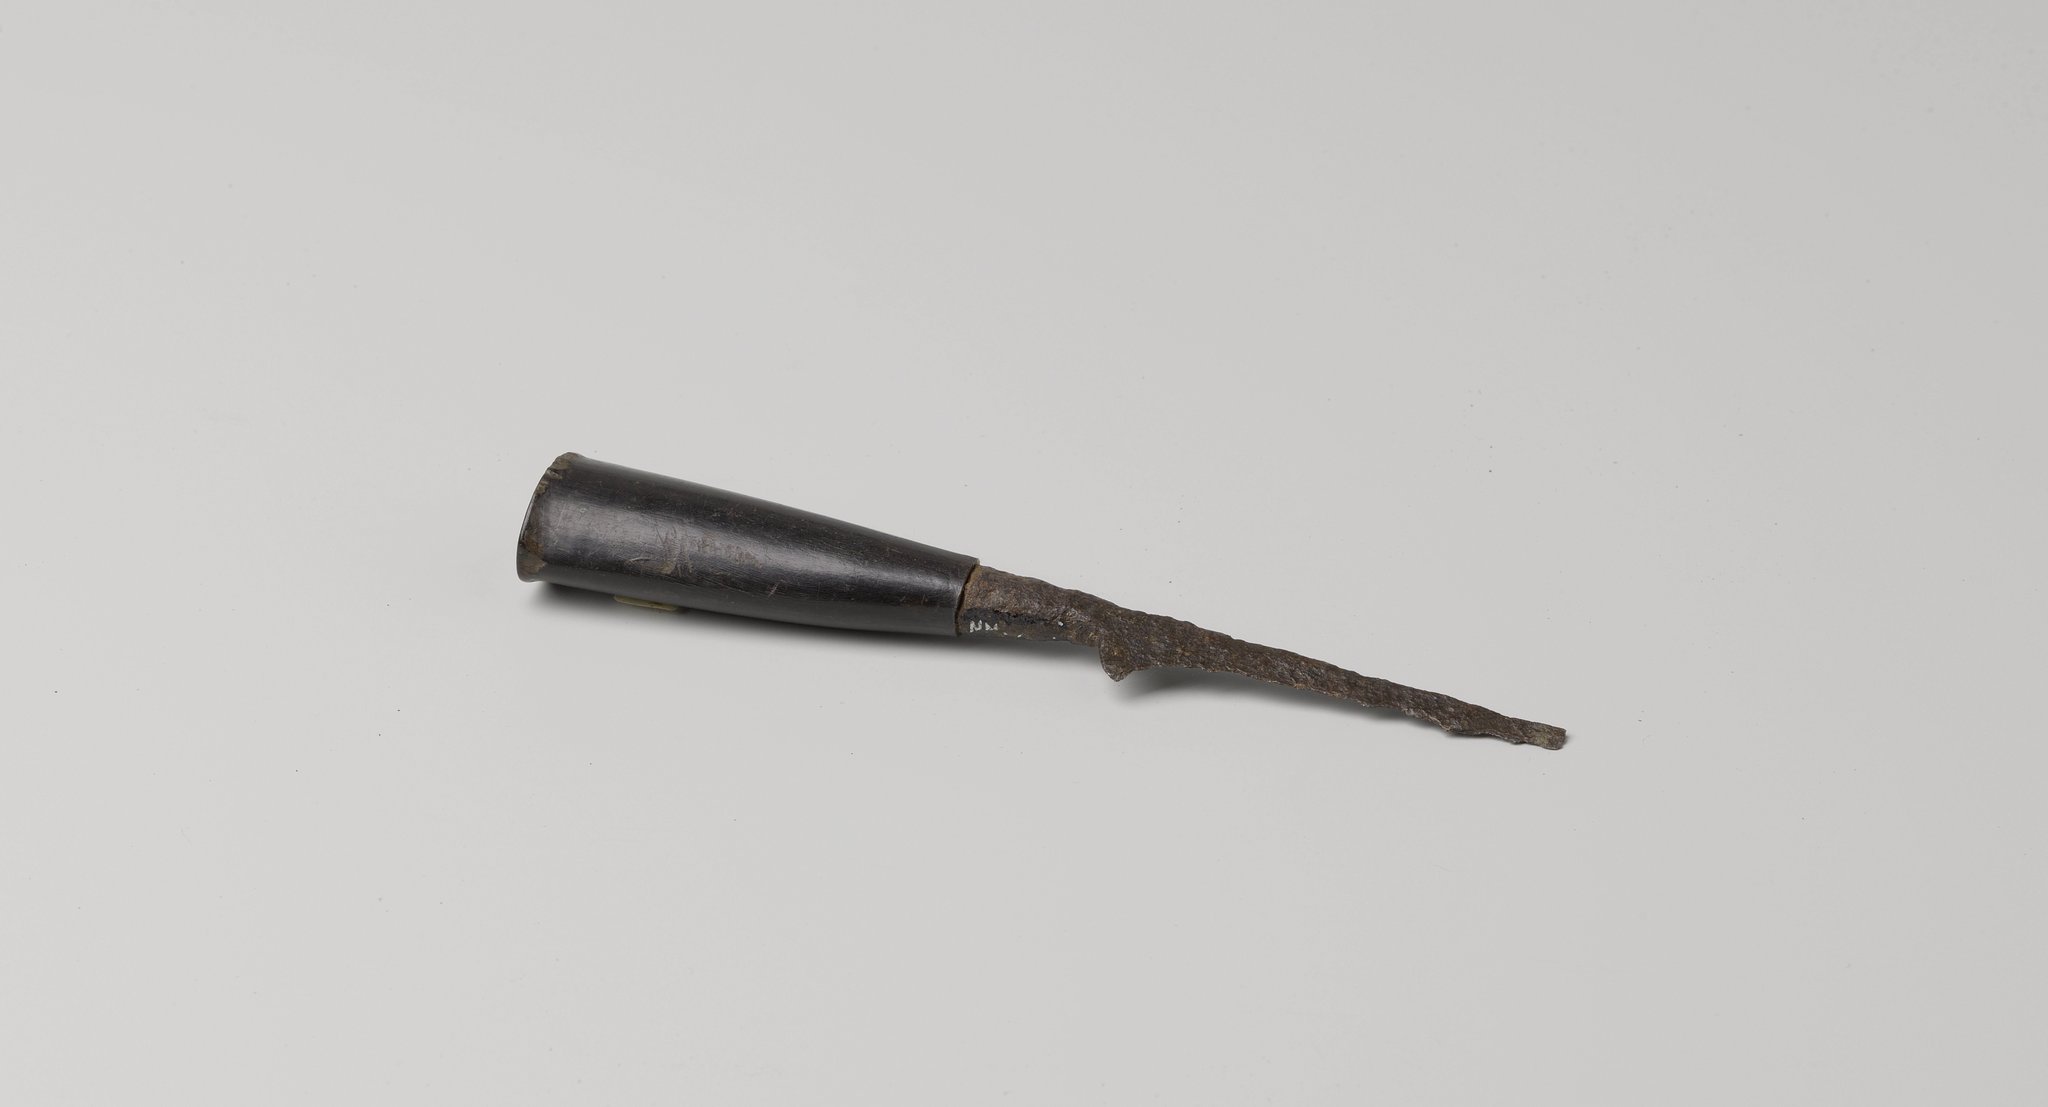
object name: table knife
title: Mes met heft met ovale doorsnede en versmalde angel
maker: Anonymous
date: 1590-1596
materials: bone, iron, wood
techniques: forging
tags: willem barendsz., amsterdam, jacob van heemskerck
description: Knives with horn and bone handles